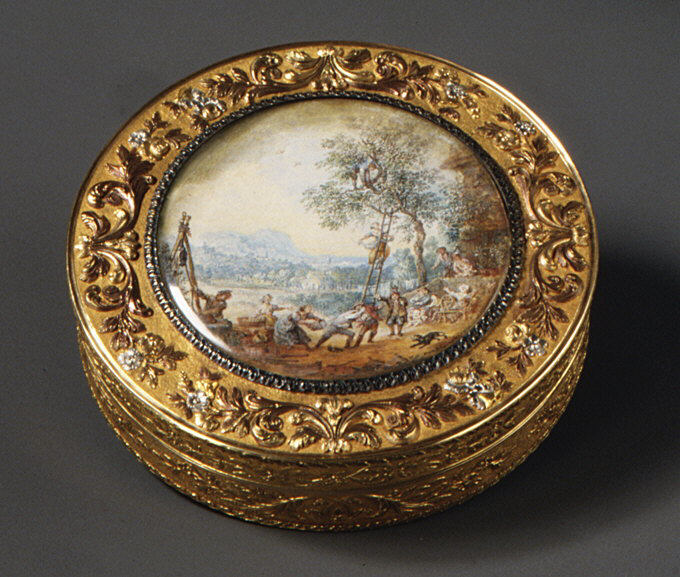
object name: snuffbox, painting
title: Snuffbox with scene of harvesting fruit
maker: johann wilhelm keibel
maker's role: maker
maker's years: 1762-1862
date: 1820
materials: gold, gouache, parchment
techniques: painting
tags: men,trees,working